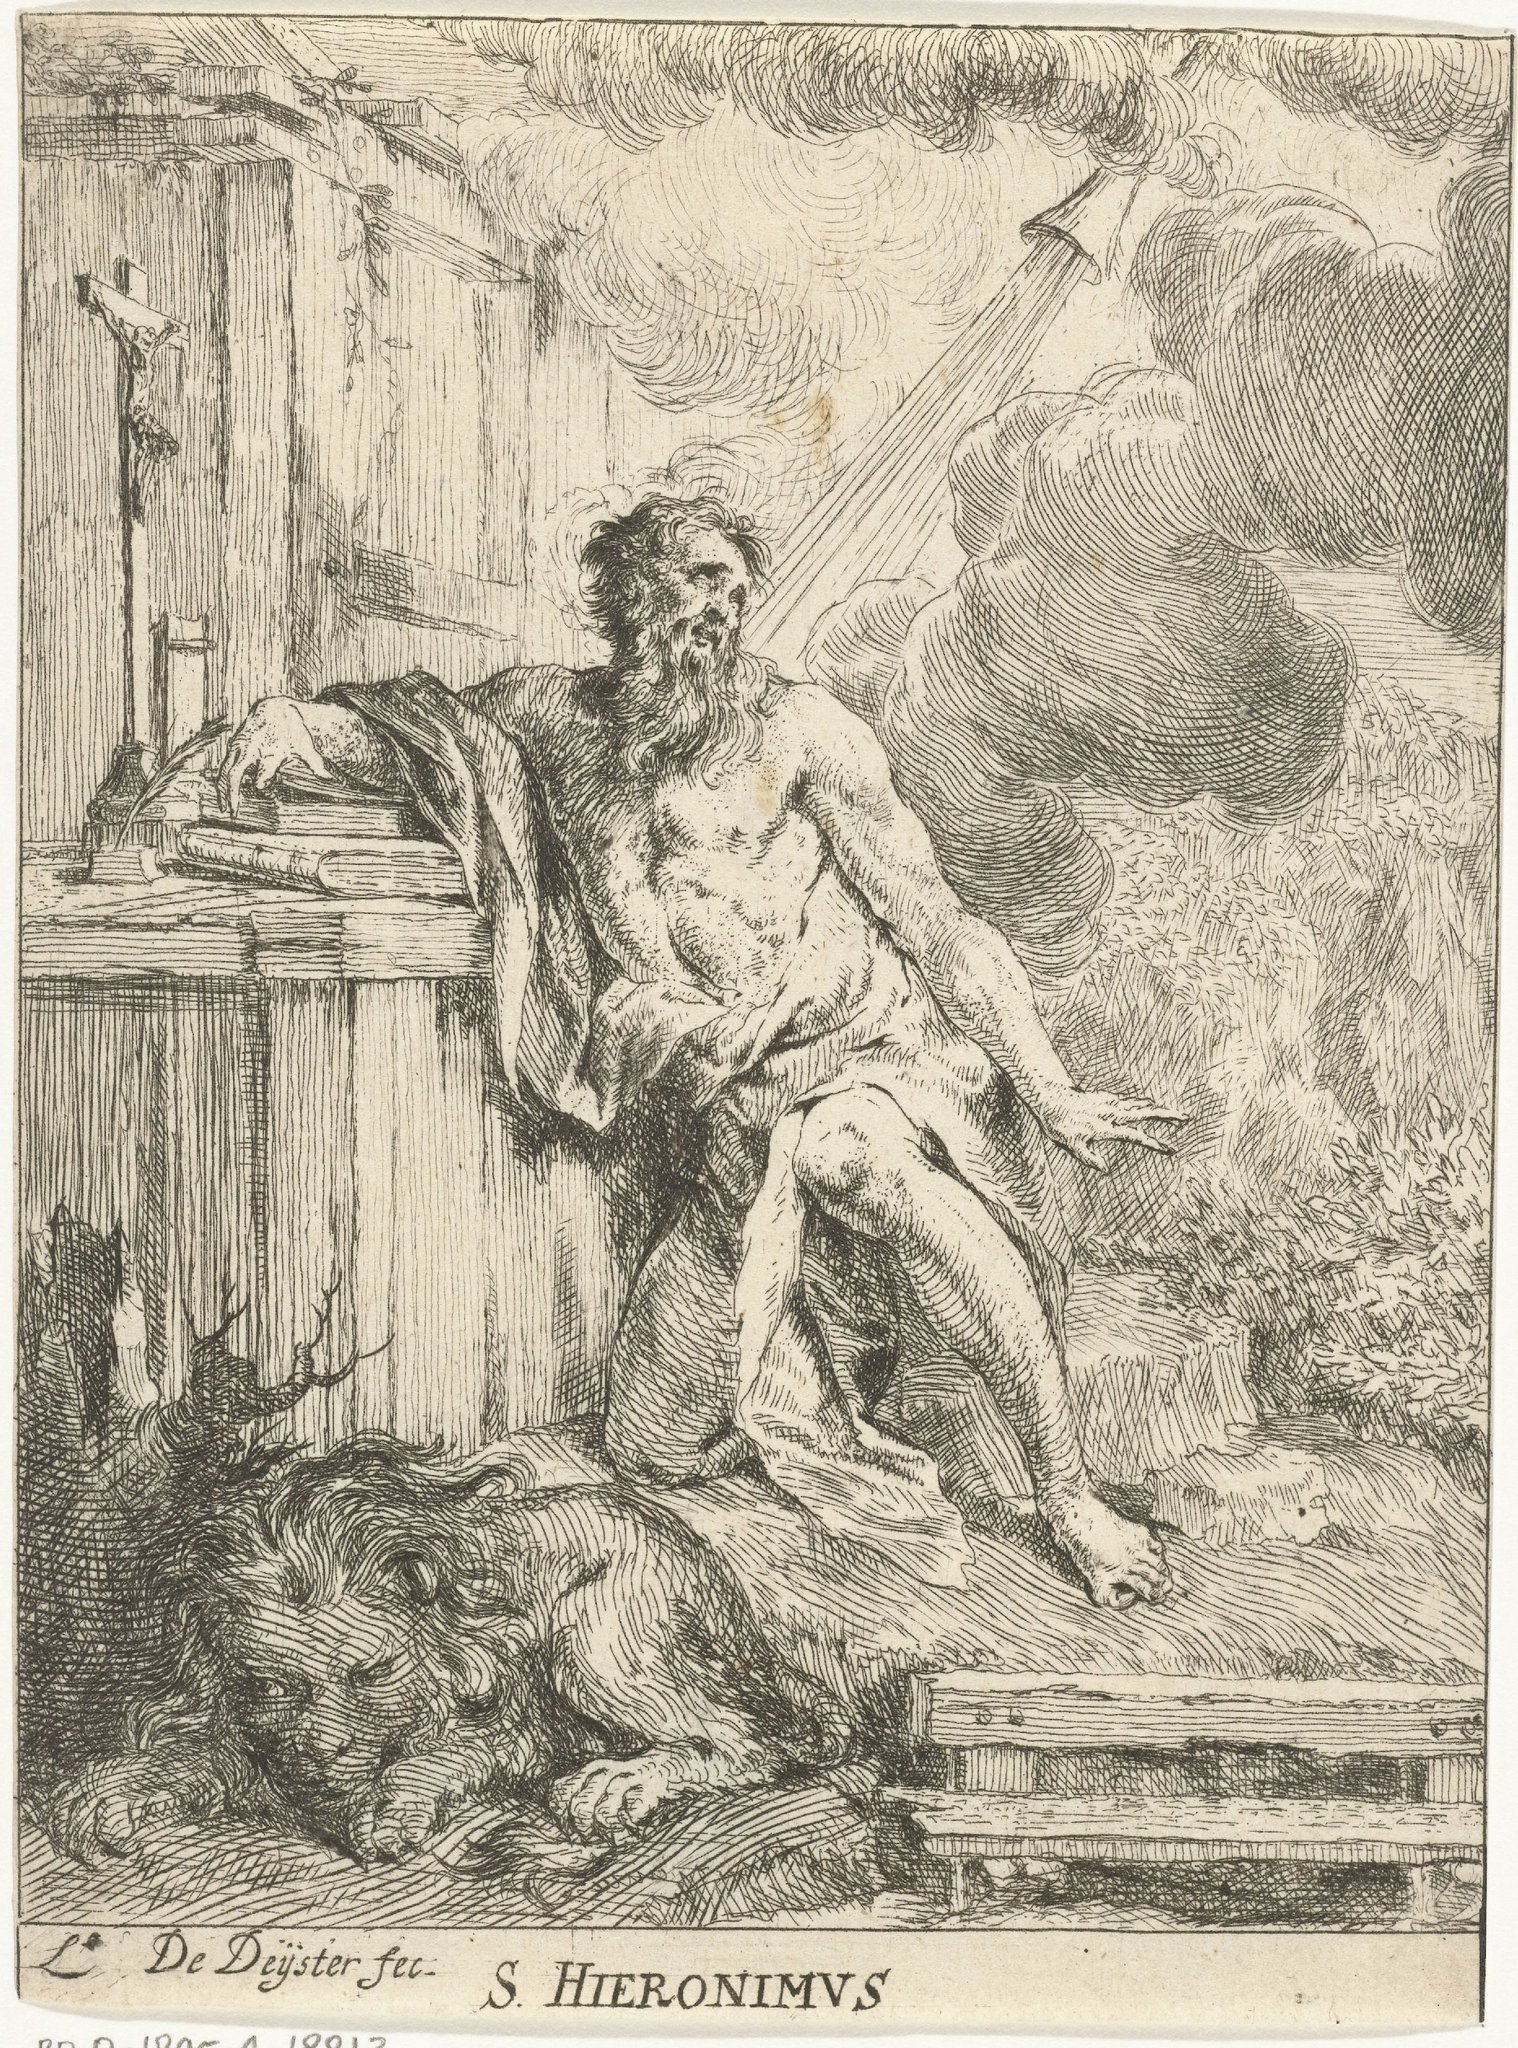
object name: print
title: Heilige Hiëronymus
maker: louis de deyster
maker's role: draughtsman, painter, print maker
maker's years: 1656-1711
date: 1666-1711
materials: paper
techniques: etching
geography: southern netherlands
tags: st. jerome as penitent in the desert, half naked, kneeling before a crucifix and holding a stone in his hand to beat his breast; a skull (and other 'vanitas' symbols), sometimes a scorpion and a snake beside him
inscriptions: collector's mark: Lugt 2228